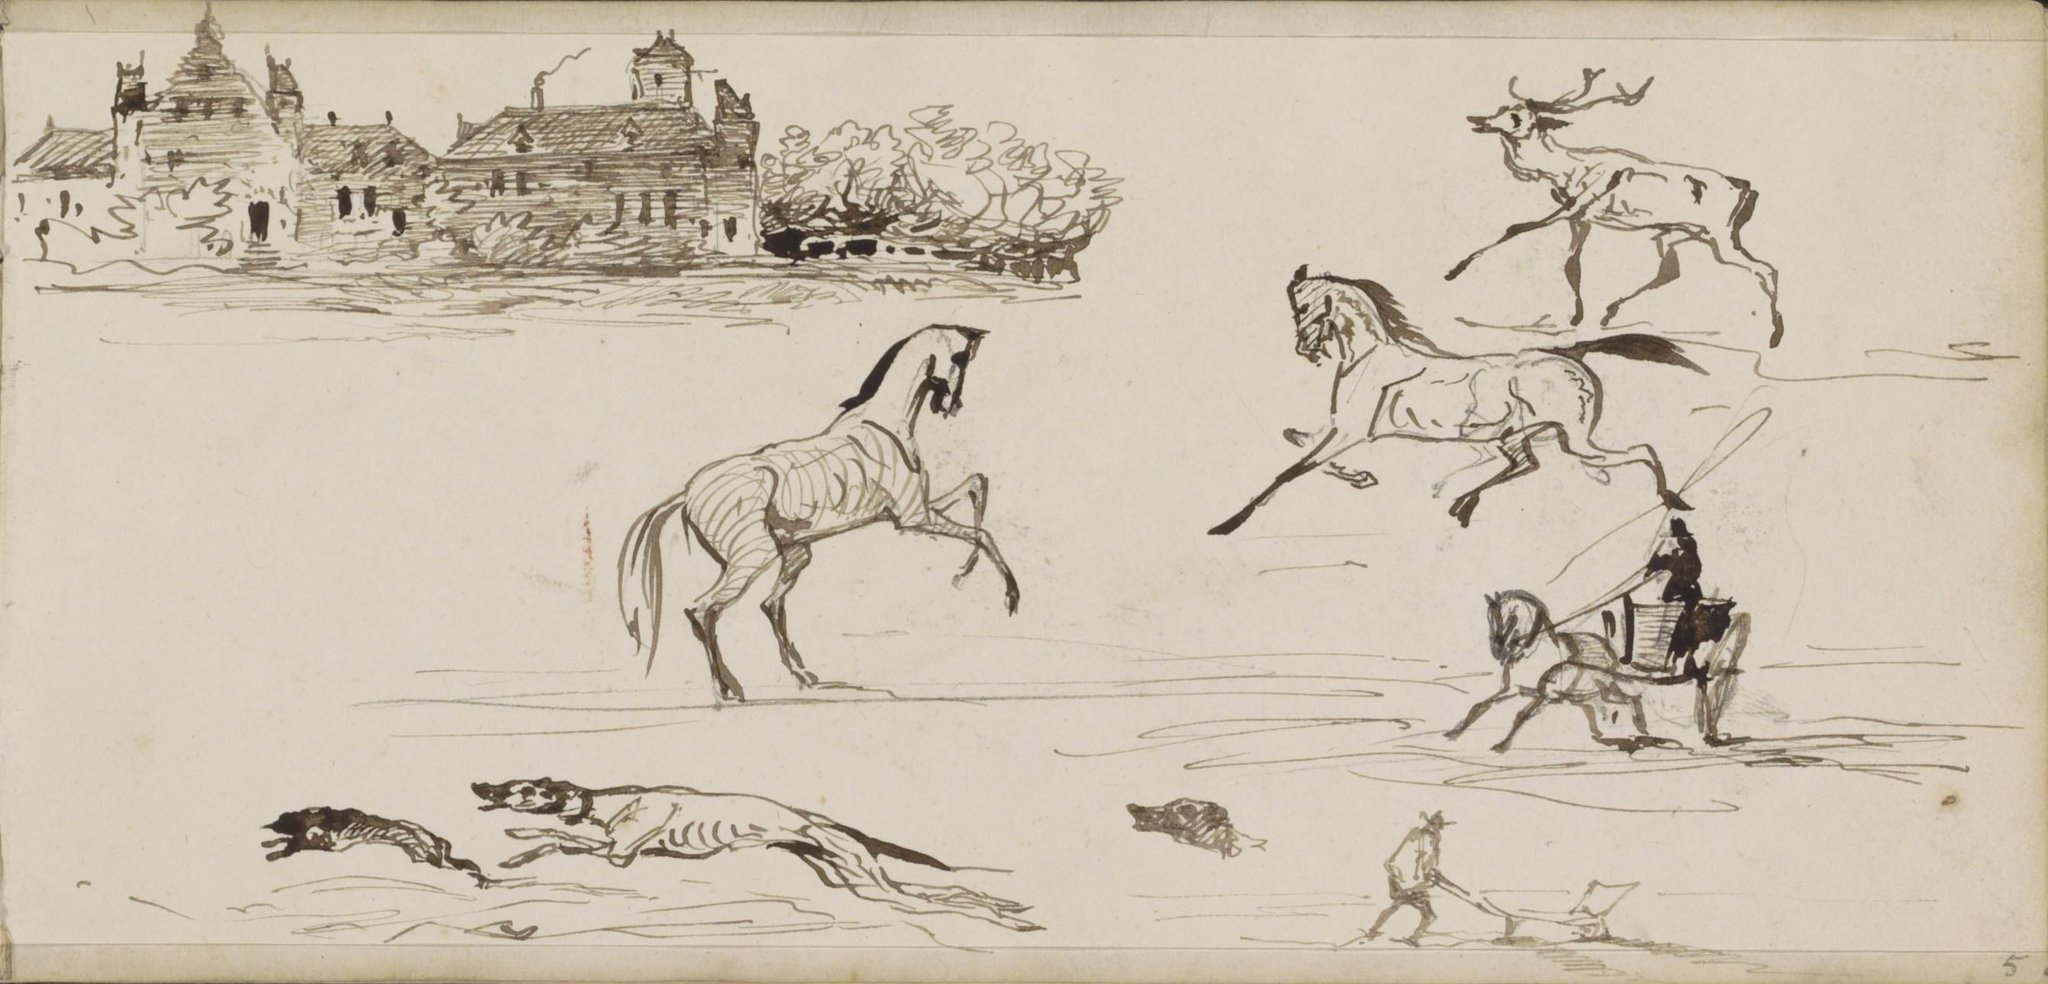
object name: sketchbook leaf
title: Stadsgezicht, paarden, een hert en honden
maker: johannes tavenraat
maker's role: draughtsman, painter, print maker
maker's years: 1809-1881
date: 1840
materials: ink, paper, pencil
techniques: pen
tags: city-view, and landscape with man-made constructions, hoofed animals: deer, horse, ploughing, dog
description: Tevens studies van een man in een paardenkar en een ploegende man. Blad 5 recto uit een schetsboek met 63 bladen.